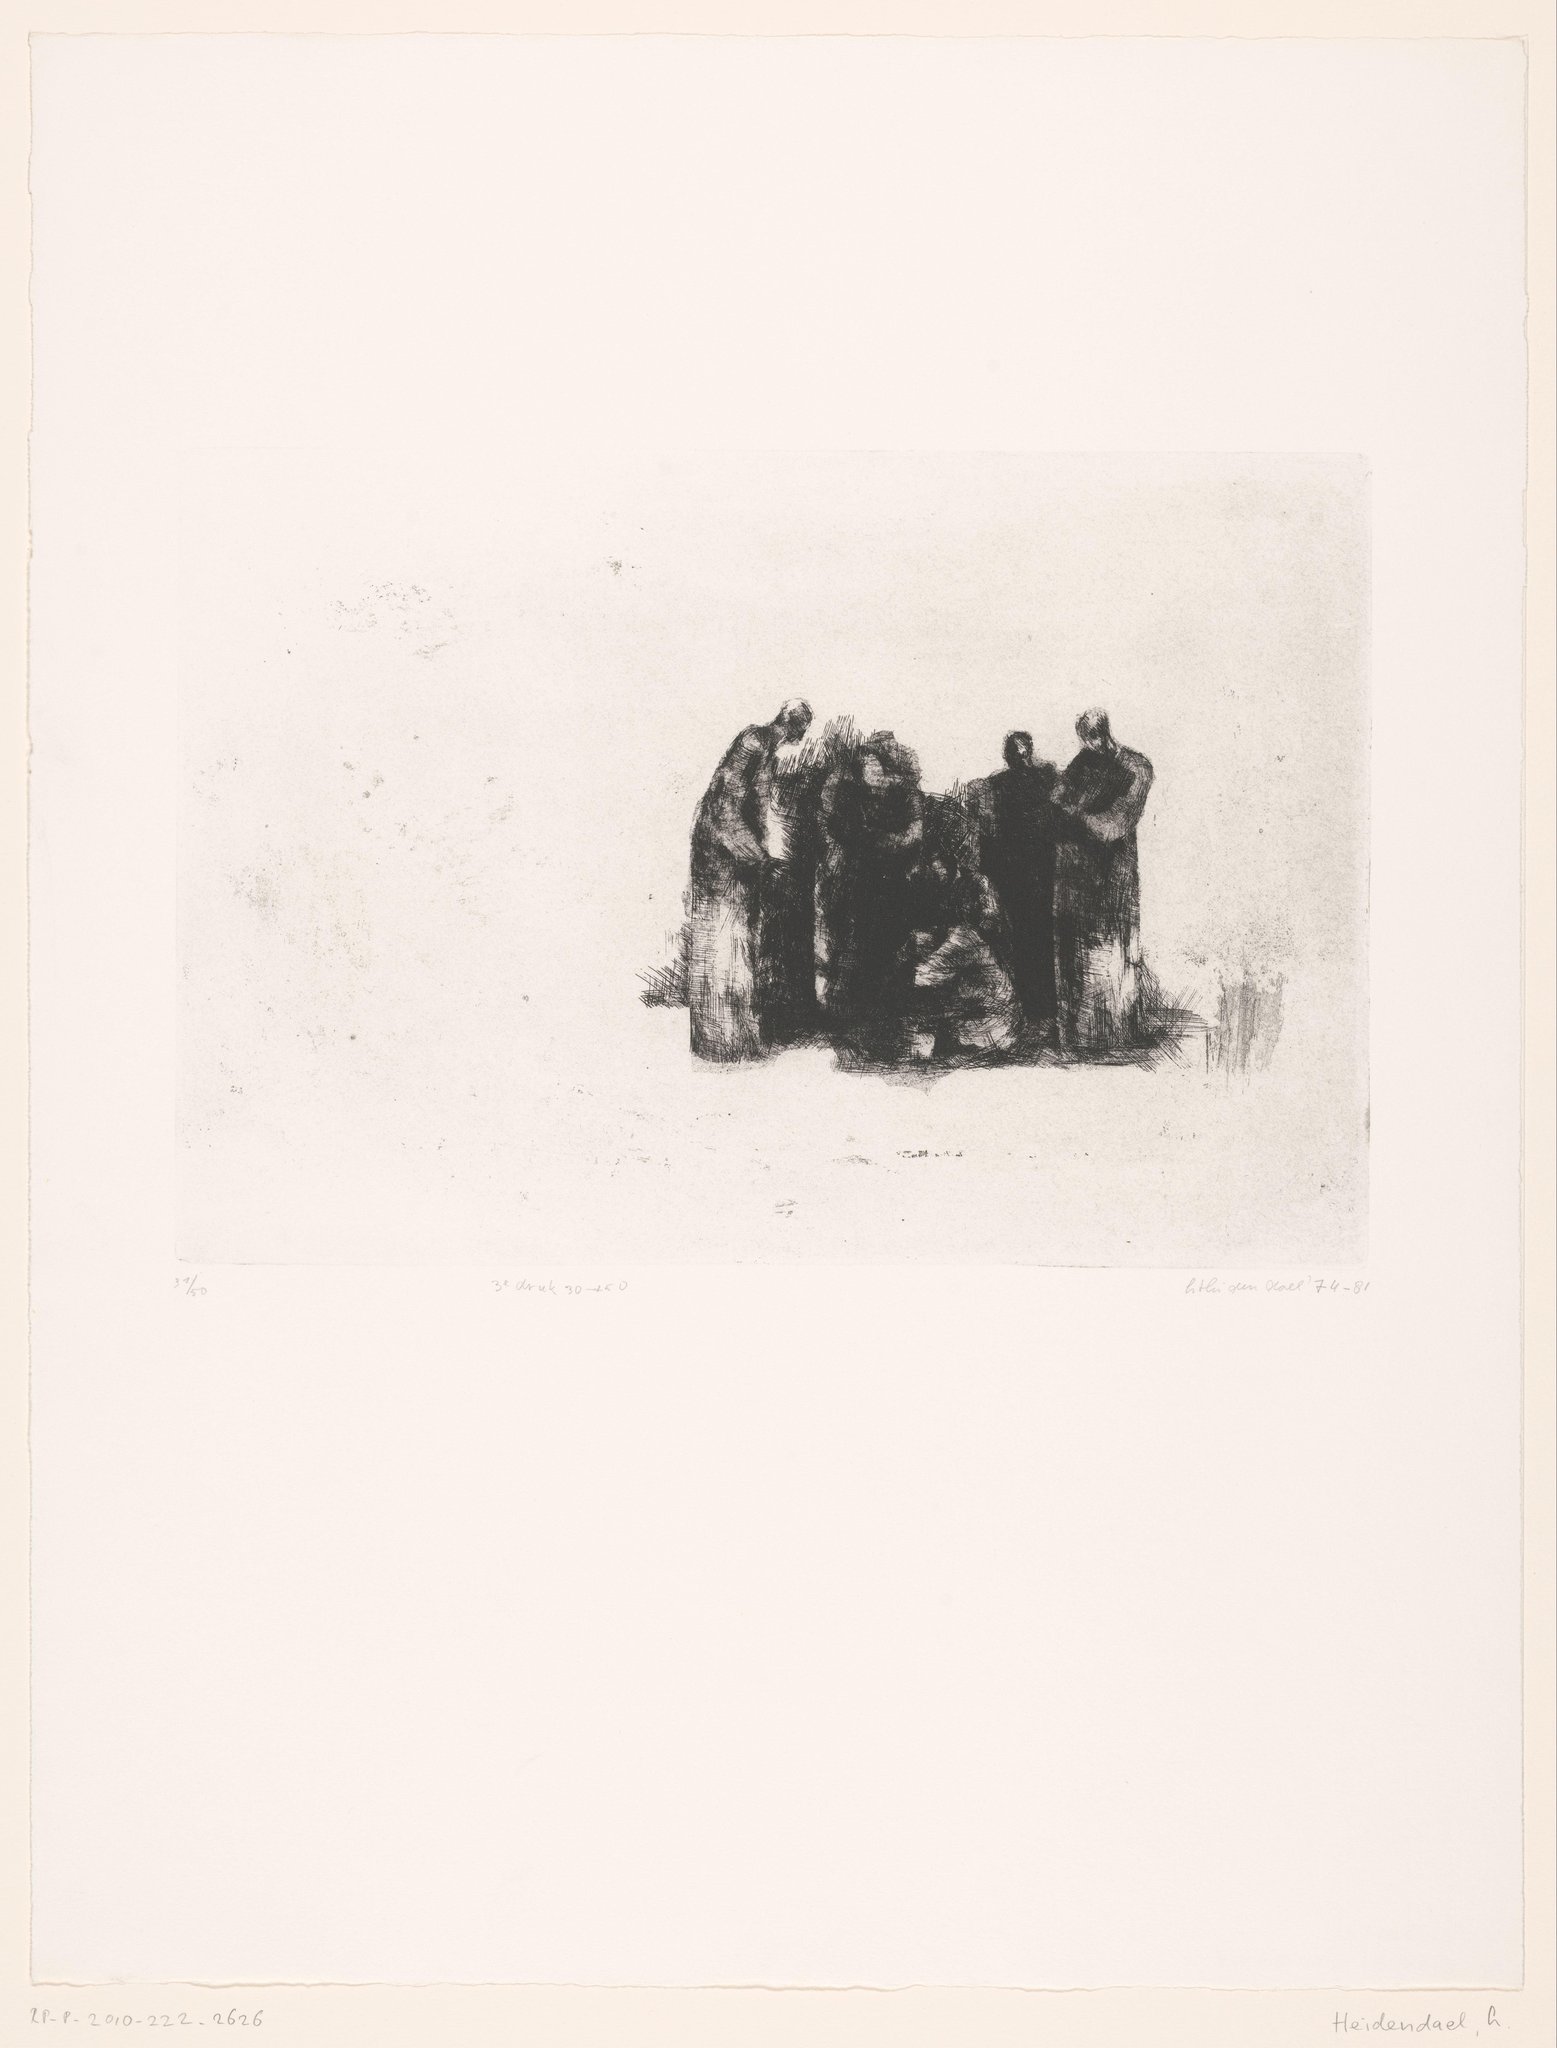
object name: print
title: Aantal donkere schimmen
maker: lau heidendael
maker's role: print maker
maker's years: 1946-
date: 1974-1981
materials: paper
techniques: etching, intaglio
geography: amsterdam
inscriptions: signature and date: ‘LHeidendael '74-81’, edition: ‘31/50’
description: Aantal donkere schimmen, opgezet in gearceerde lijnen.